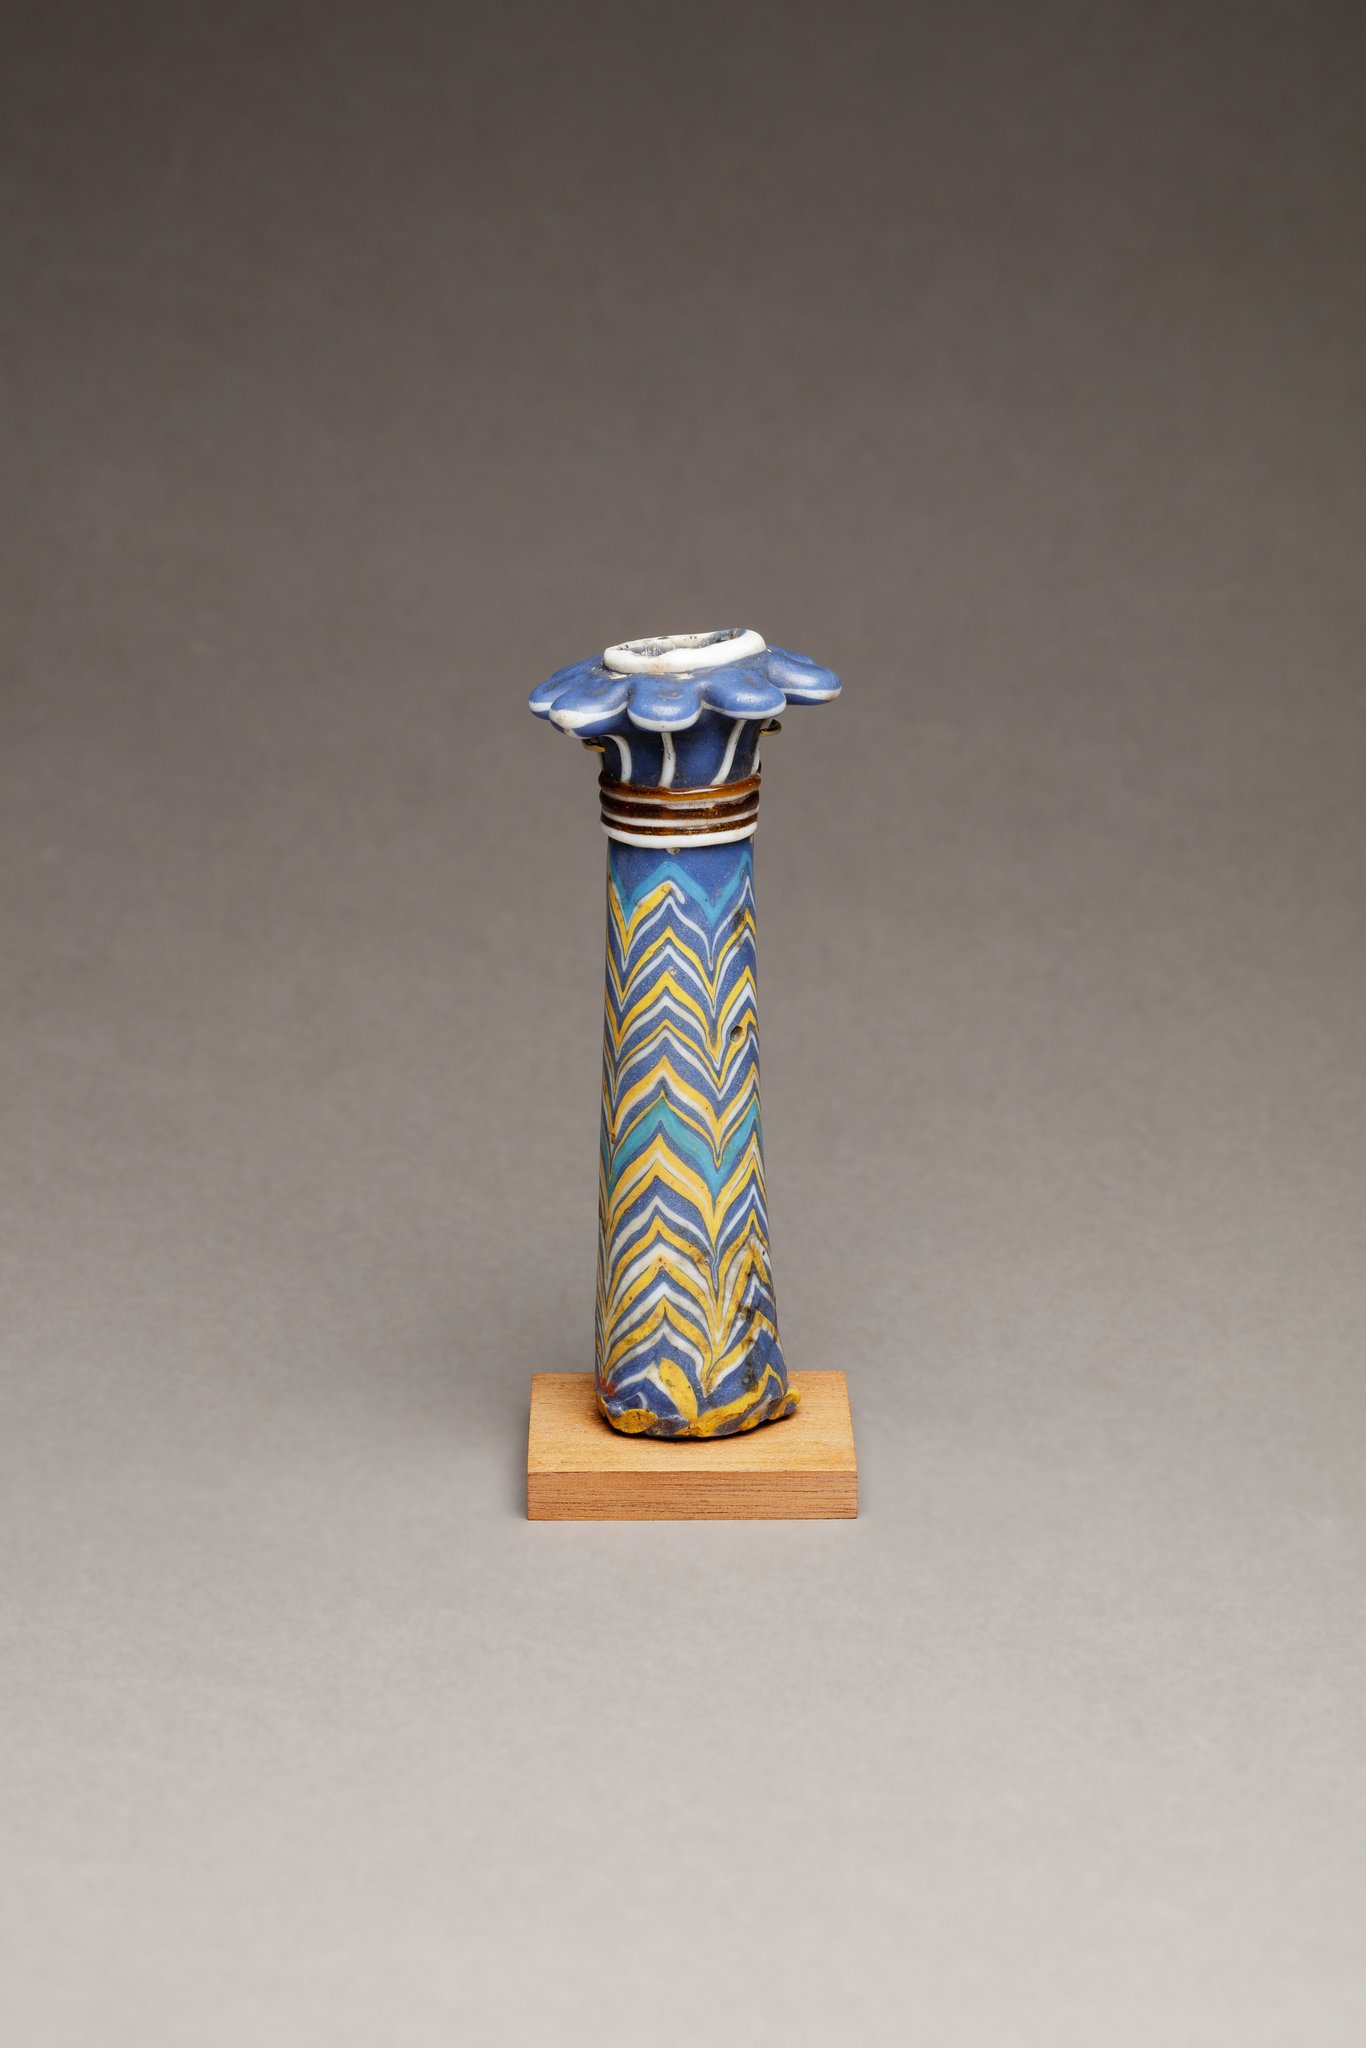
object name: kohl tube, papyrus column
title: Kohl Tube in the Shape of a Papyrus Column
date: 1390-1352 BCE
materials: glass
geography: egypt